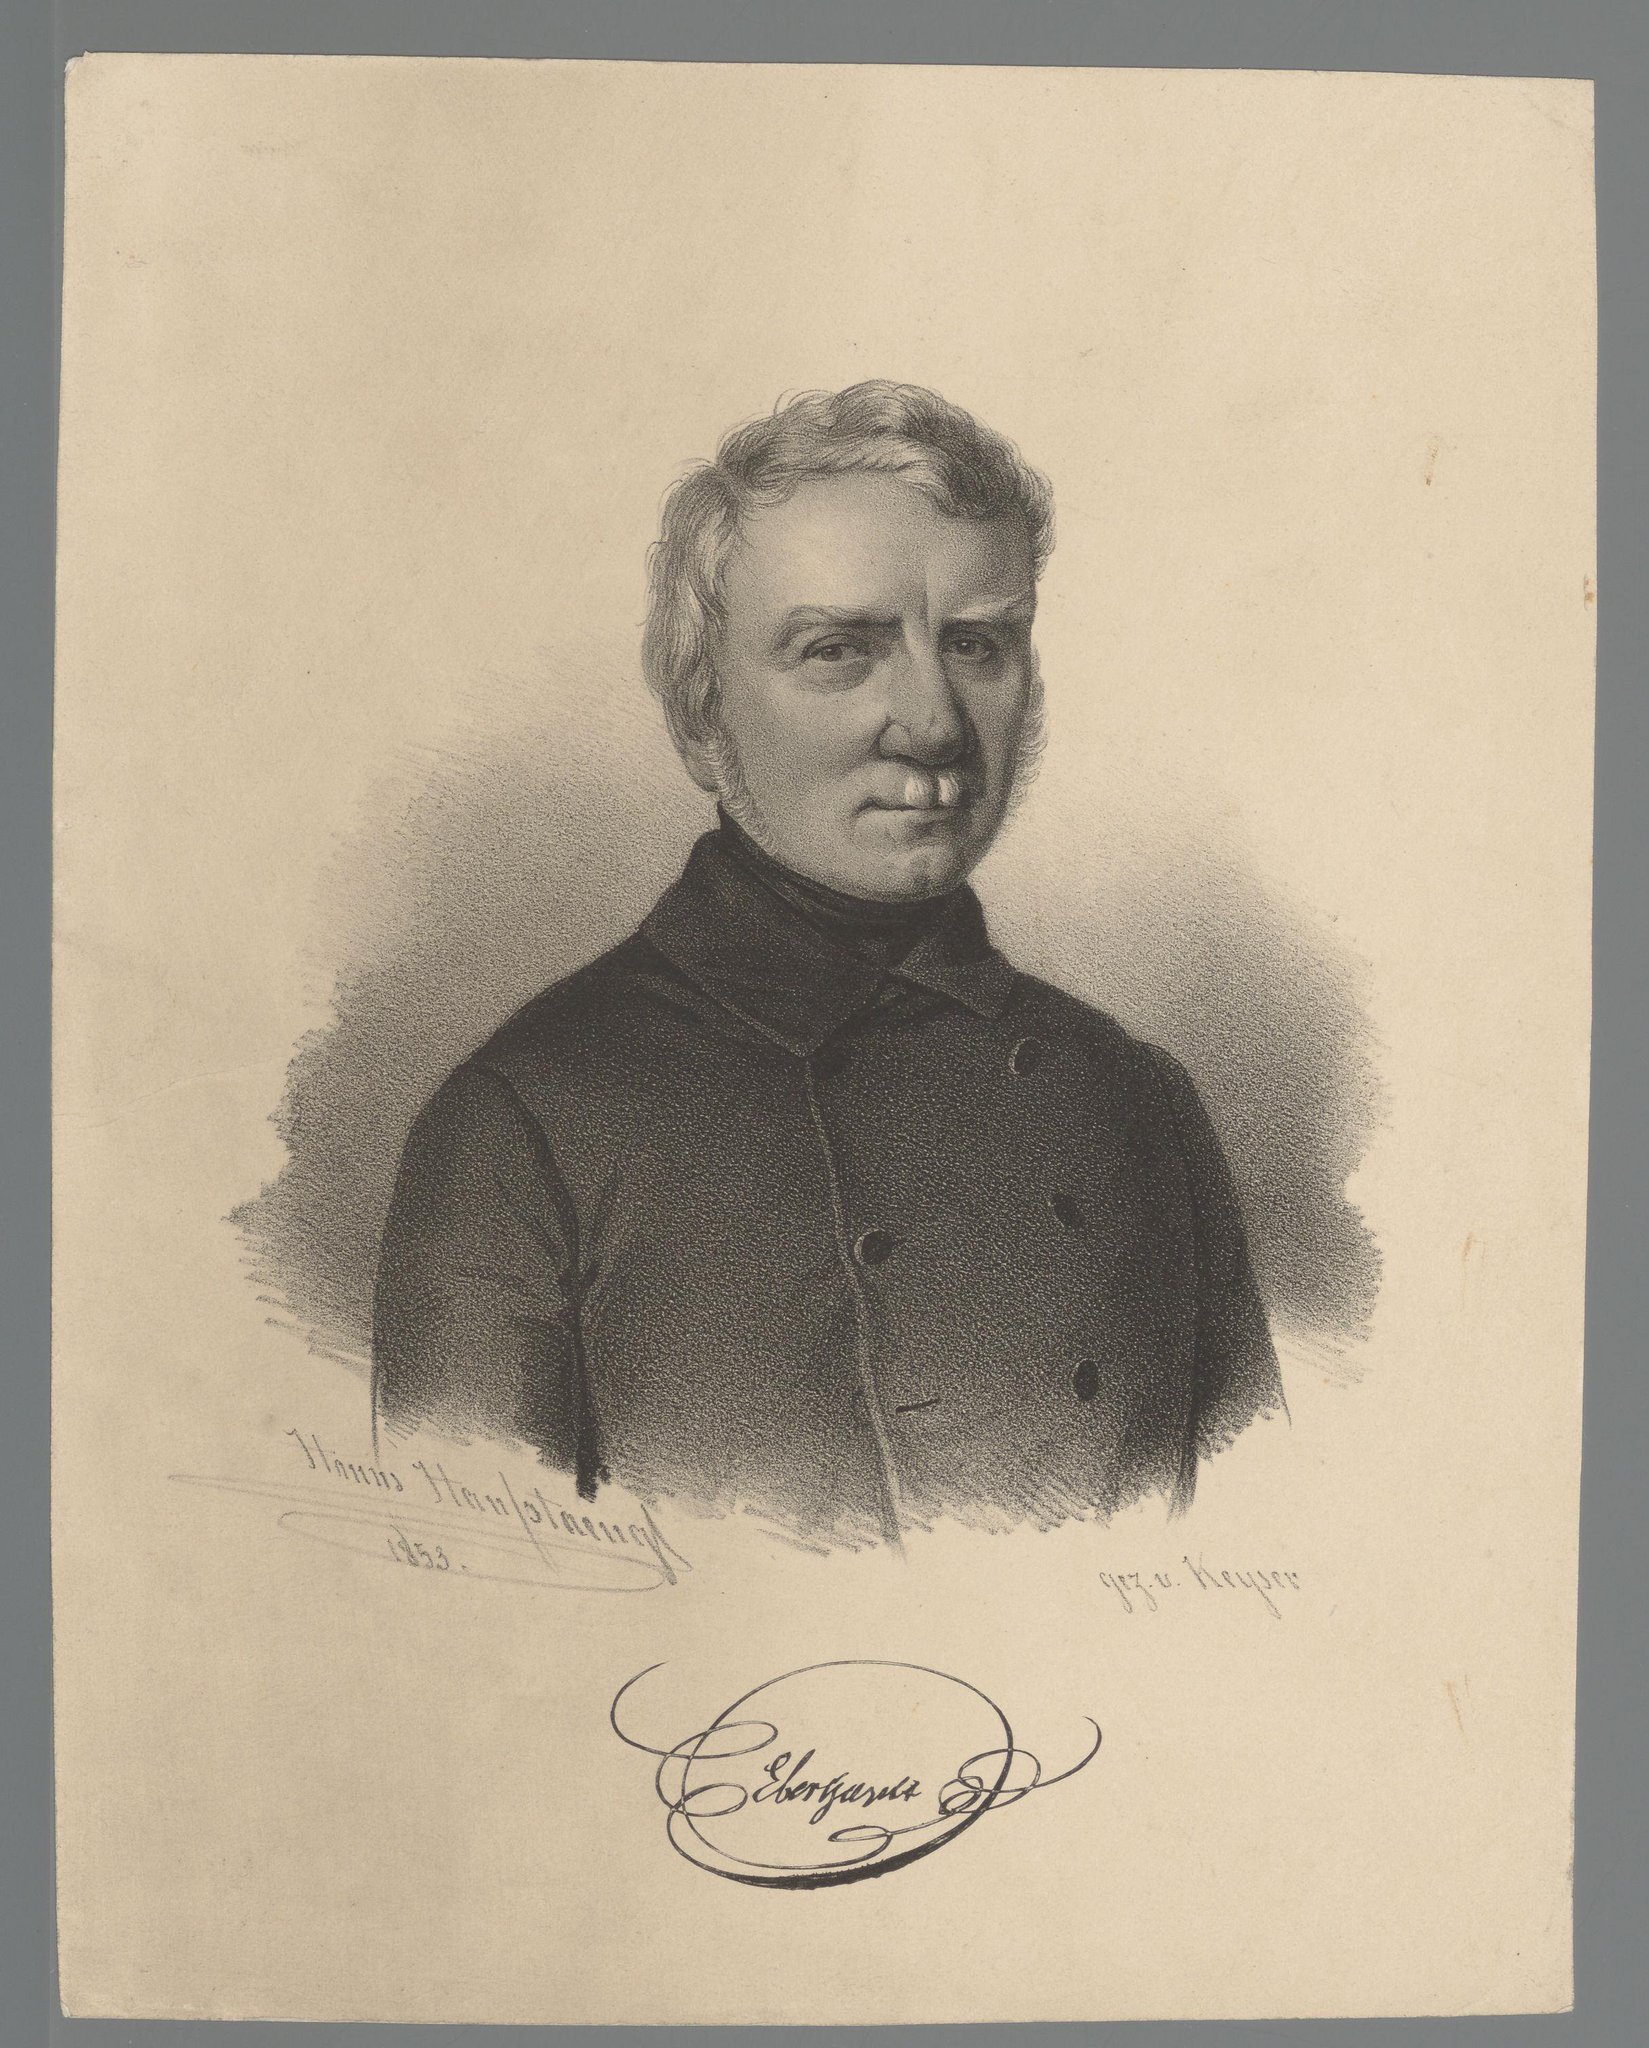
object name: print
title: Portret van een onbekende man, mogelijk C. Ebergardt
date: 1853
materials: paper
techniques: lithograph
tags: moustache, adult man, historical persons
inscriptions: collector's mark: Lugt 2228